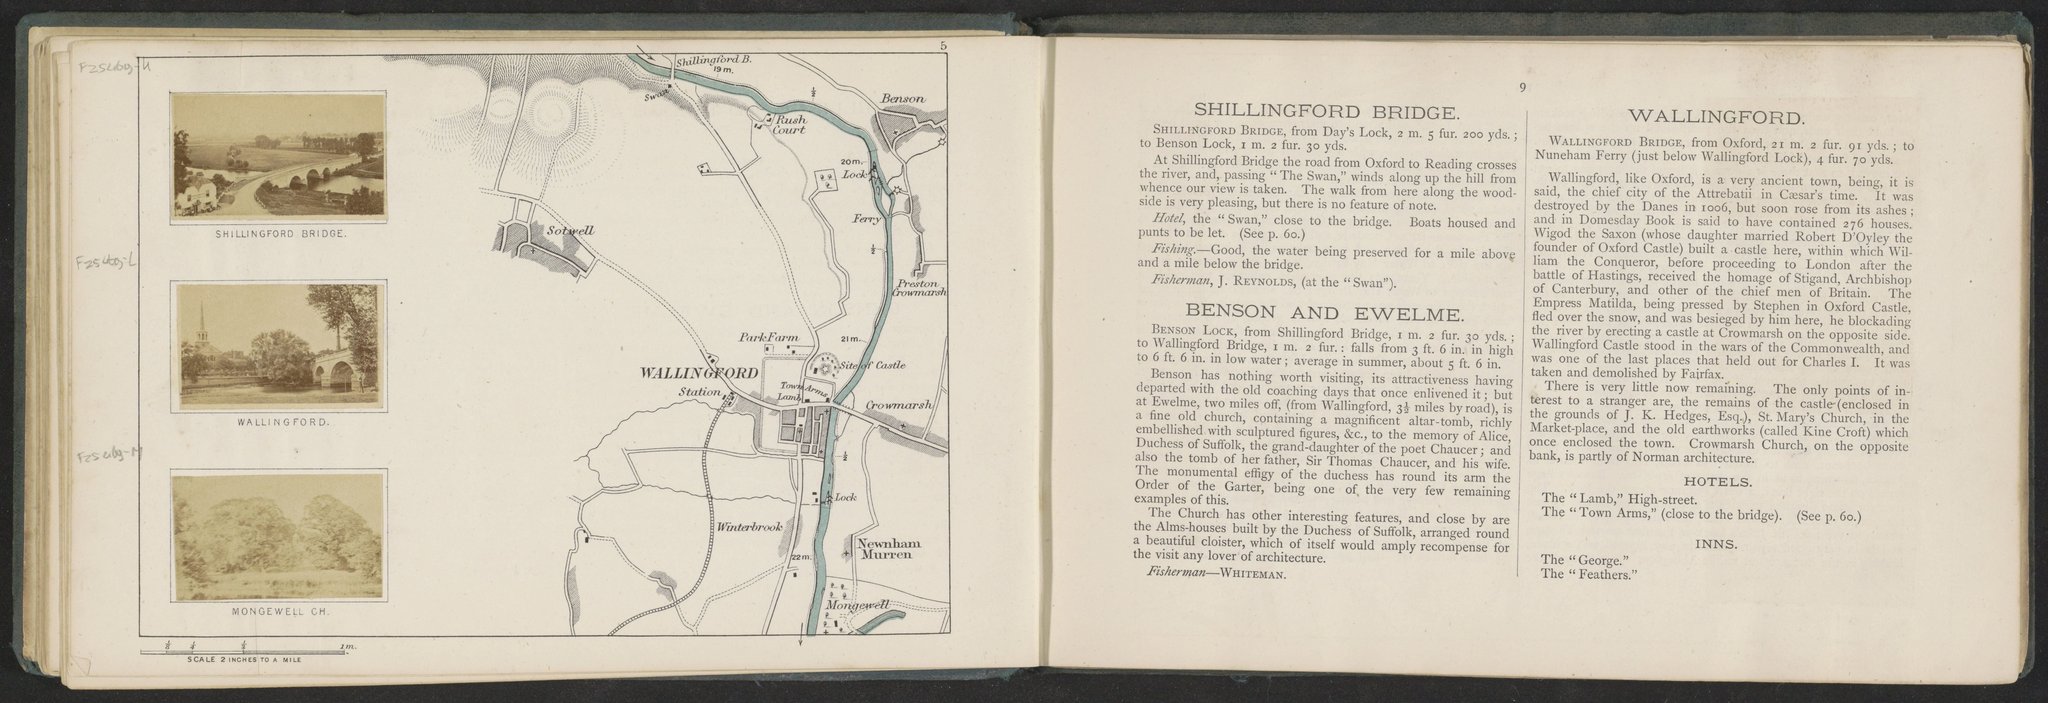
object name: page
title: Gezicht op een brug over de Theems bij Shillingford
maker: henry w. taunt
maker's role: fotograaf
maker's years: 1842-1922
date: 1871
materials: photographic support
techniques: albumen print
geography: shillingford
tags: bridge, thames